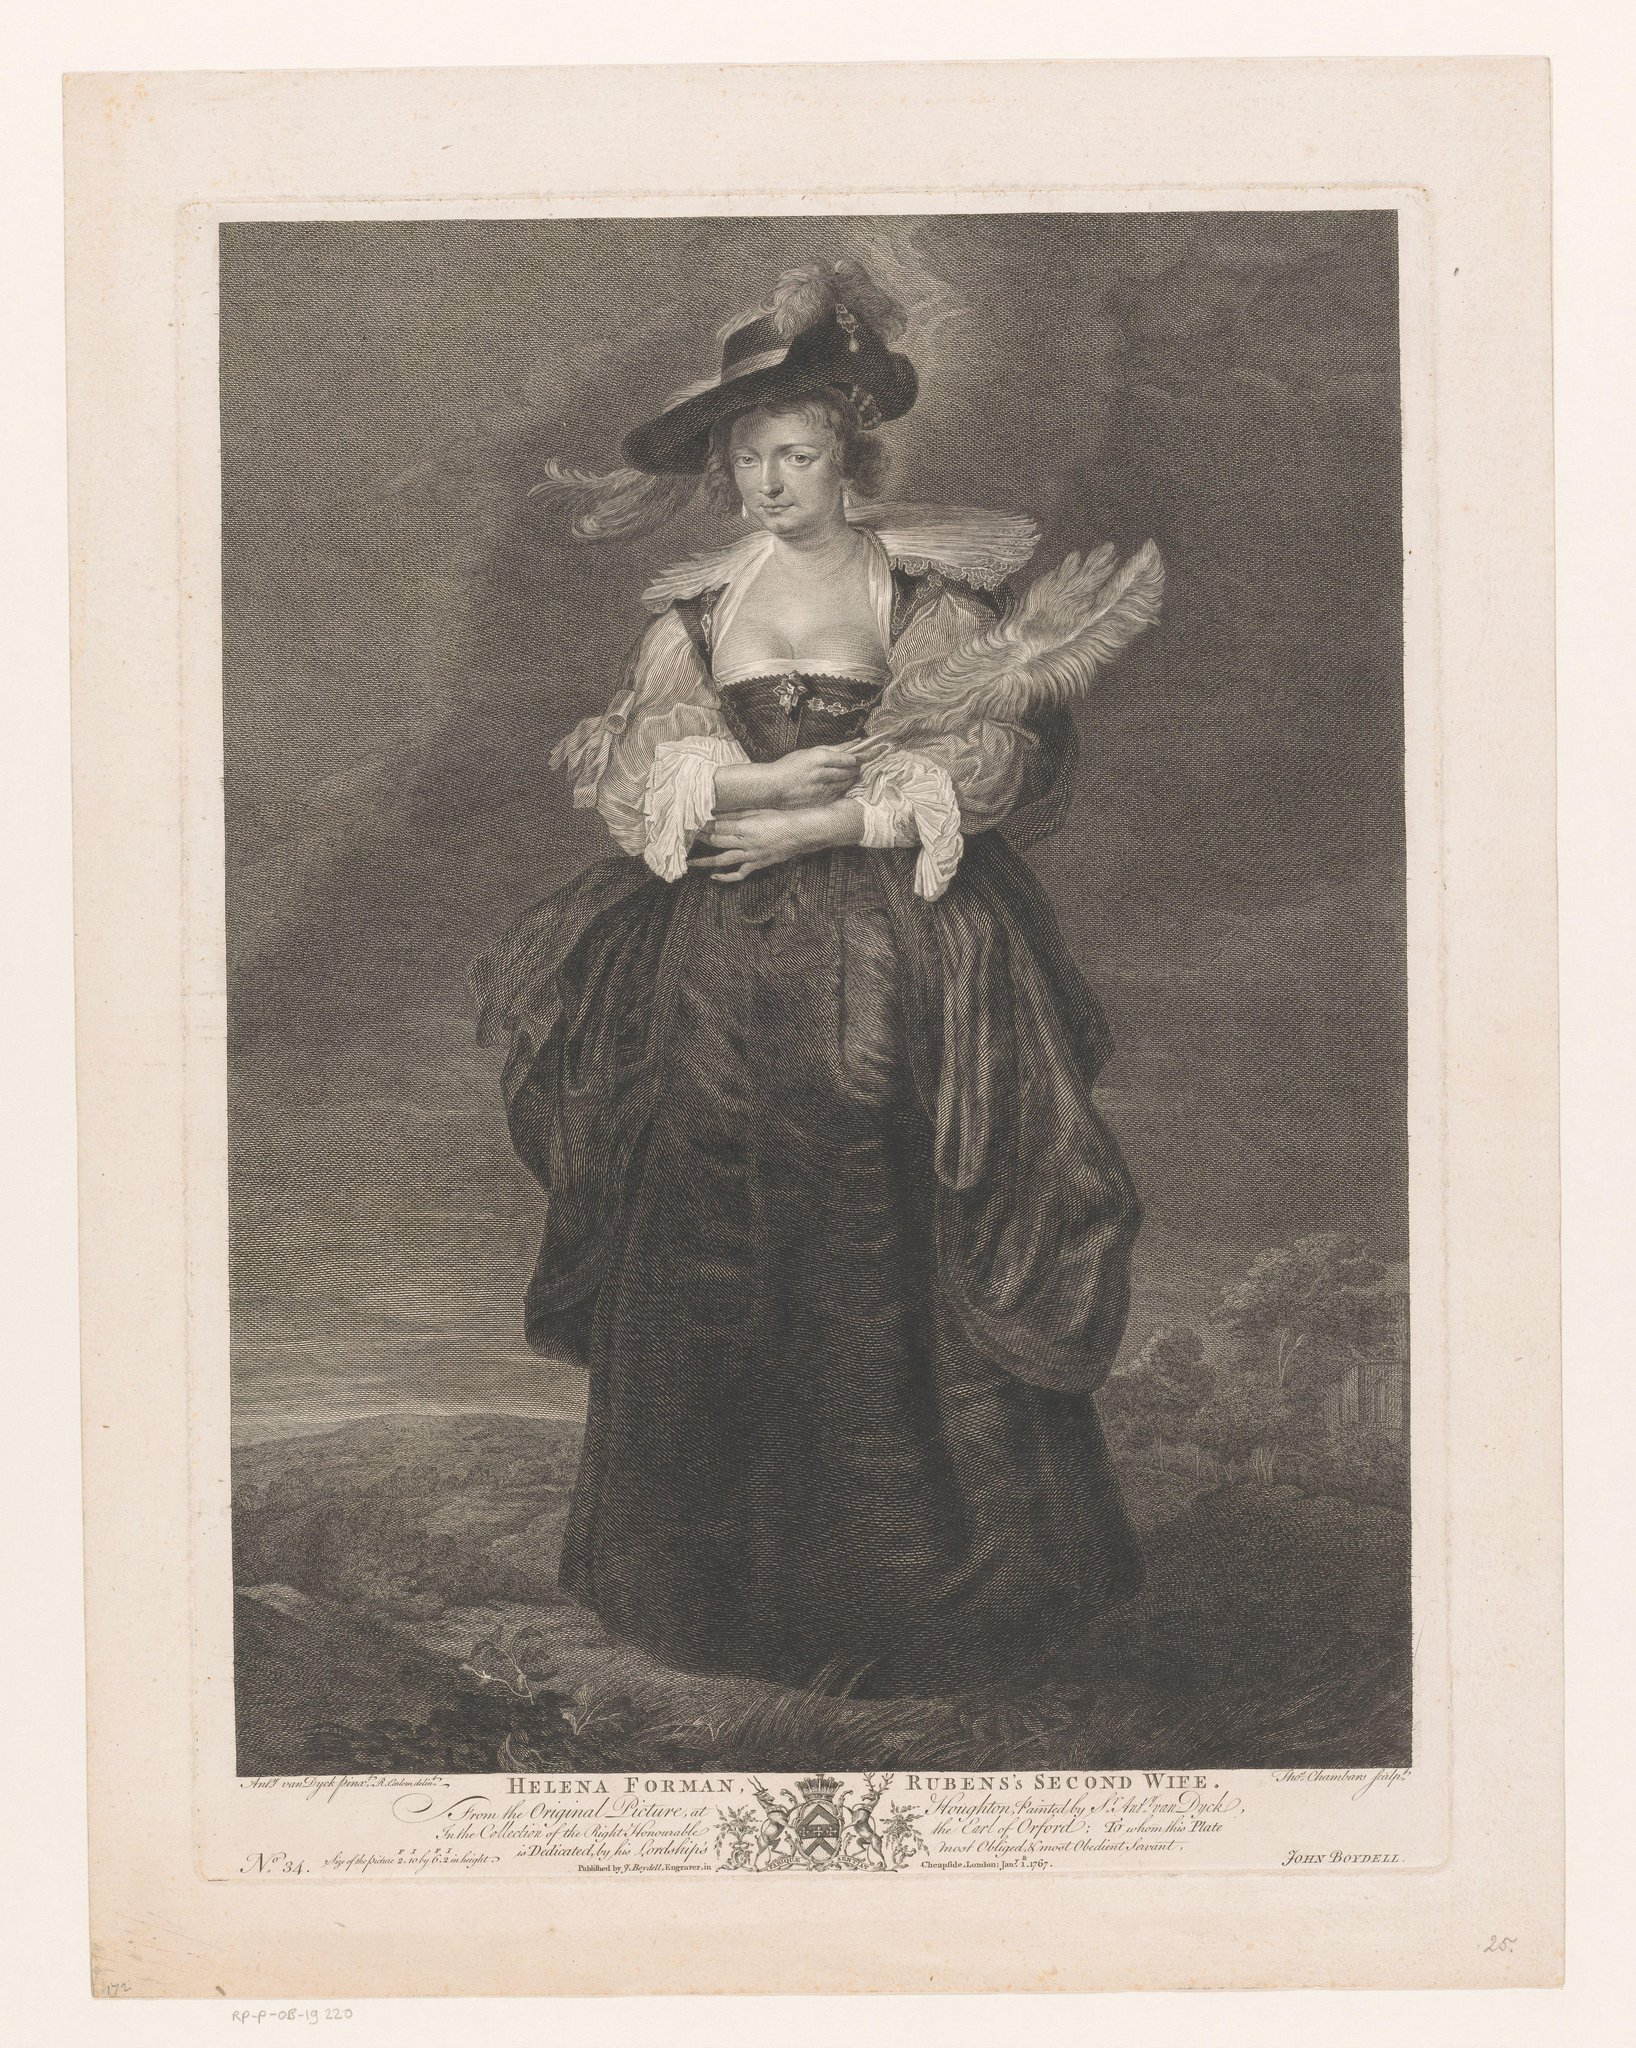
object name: print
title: Schilderijen uit The Houghton Gallery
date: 1701-1767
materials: paper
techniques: etching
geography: london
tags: antwerp, historical persons - bb - woman, head-gear: hat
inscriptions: collector's mark: Lugt 2228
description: Het schilderij is gemaakt door Rubens en niet, zoals de prent vermeld, door Van Dyck. Prent is onderdeel van een serie van 162 prenten naar schilderijen uit de collectie verzameld door Sir Robert Walpole in Houghton, op initiatief van uitgever John Boydell. De meeste prenten uit deze serie werden tussen 1774 en 1788 uitgegeven en in twee volumes bijeengebracht. Deze prent werd voor het eerst in 1767 uitgegeven en werd later aan volume twee toegevoegd. Mogelijk is de prent in 1767 uitgegeven als onderdeel van de serie 'Most Capital Paintings in England.'